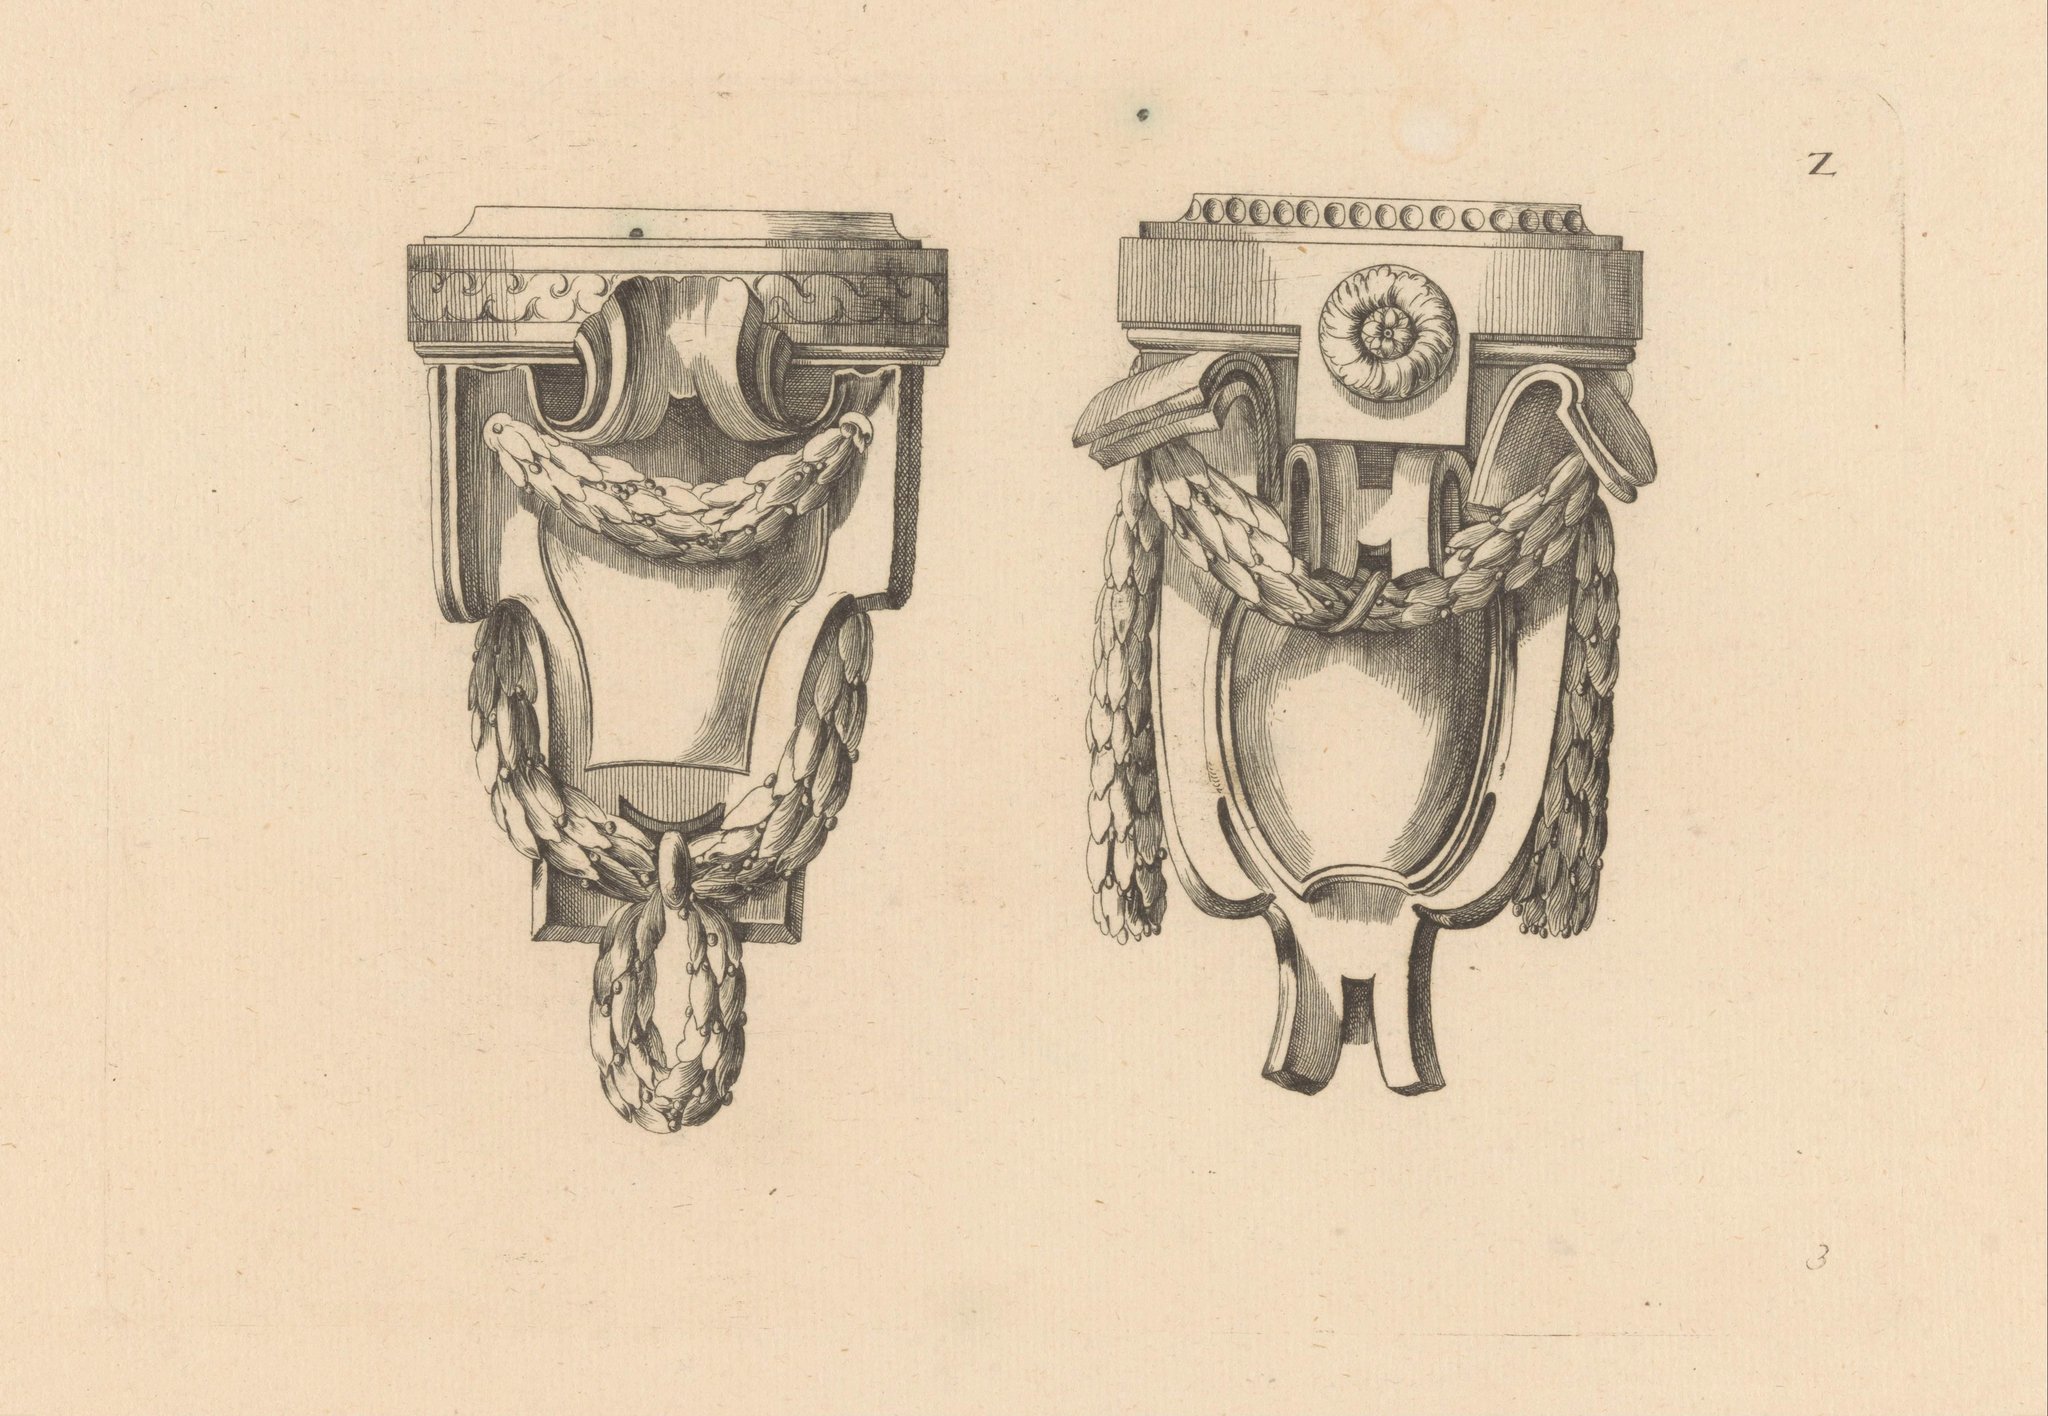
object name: print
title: Consoles dans le Goût antique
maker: gottlieb friedrich riedel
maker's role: print maker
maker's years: 1724-1784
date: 1771-1784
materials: paper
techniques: etching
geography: augsburg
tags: other architectural details (console), ornament ~ festoon, garland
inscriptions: collector's mark: Lugt 2228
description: Twee console met guirlandes. Rechts boven Z genummerd, rechts onder 3 genummerd.